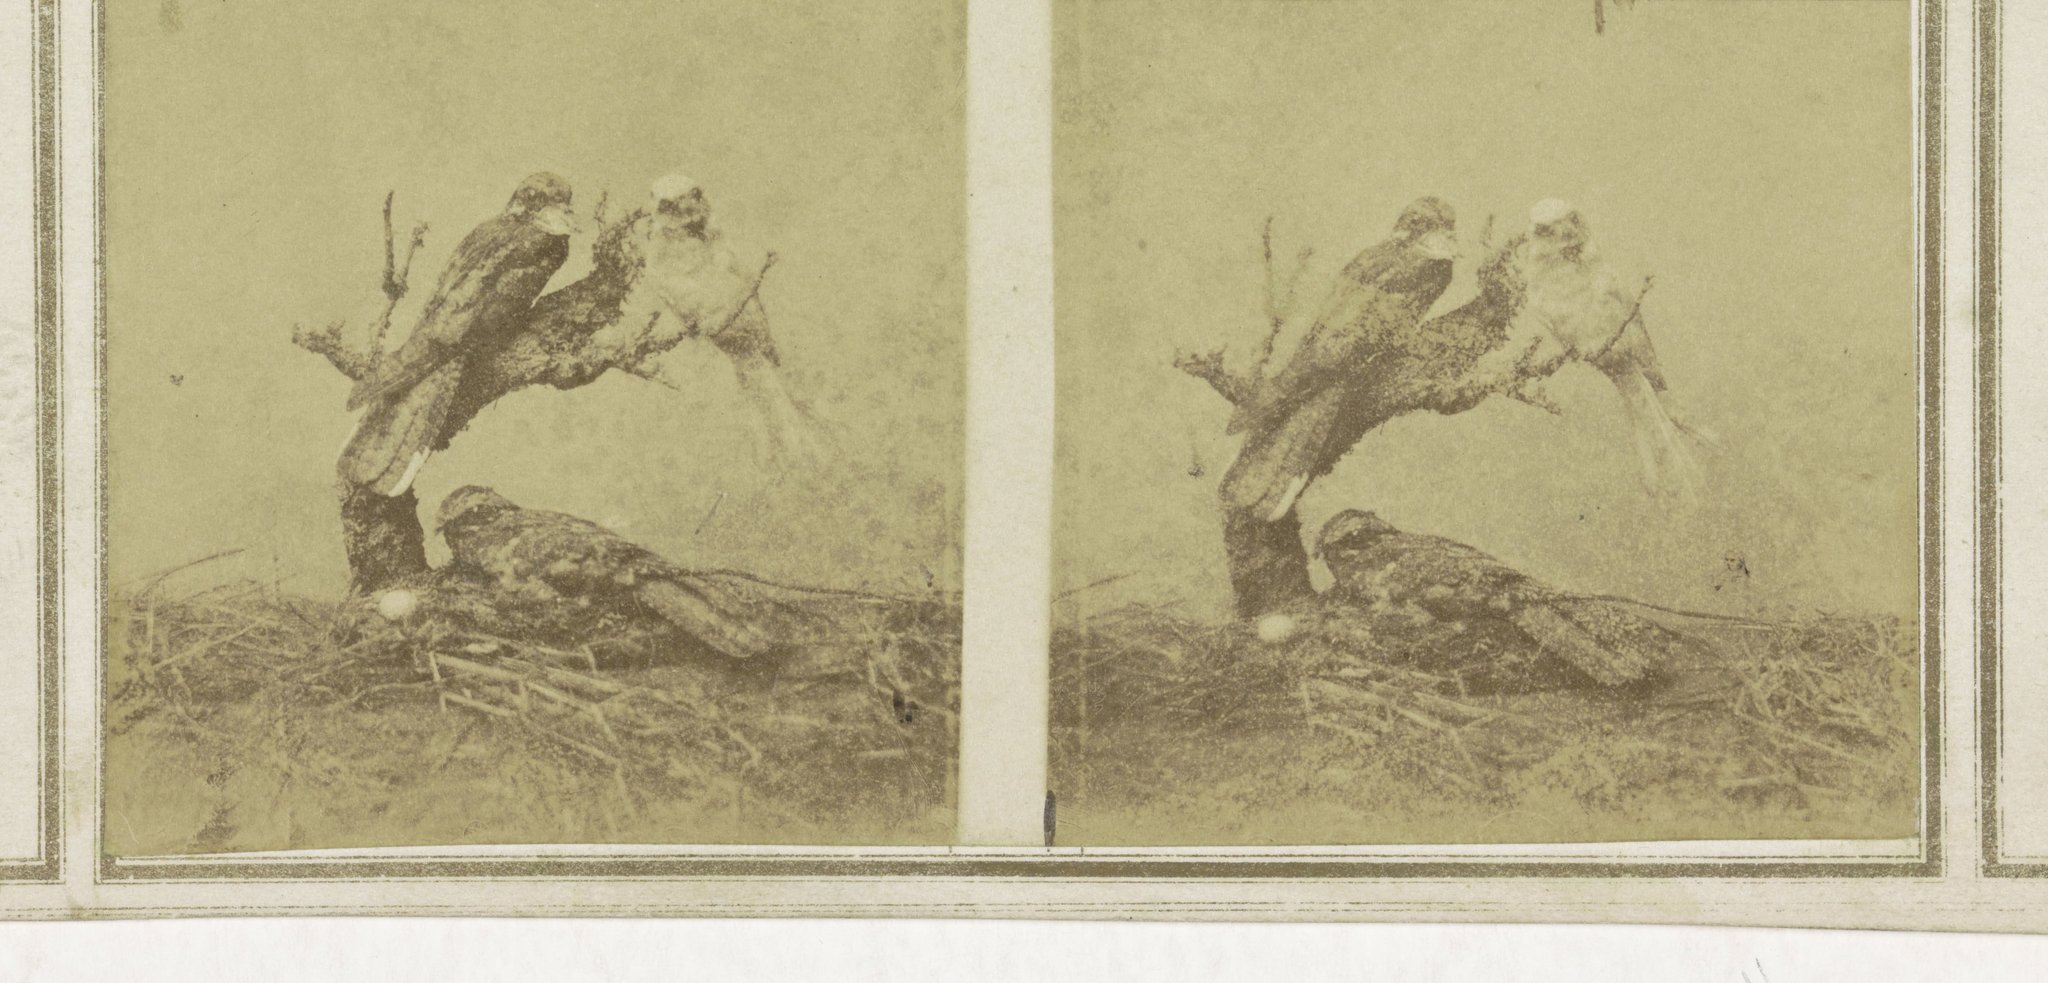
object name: stereograph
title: Drie vogels waarvan er twee op een tak zitten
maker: pierre-ambroise richebourg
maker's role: fotograaf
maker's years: 1810-1875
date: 1850-1870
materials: photographic support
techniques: albumen print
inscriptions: check stamp: ‘monogram LM (?)’, number: ‘55’